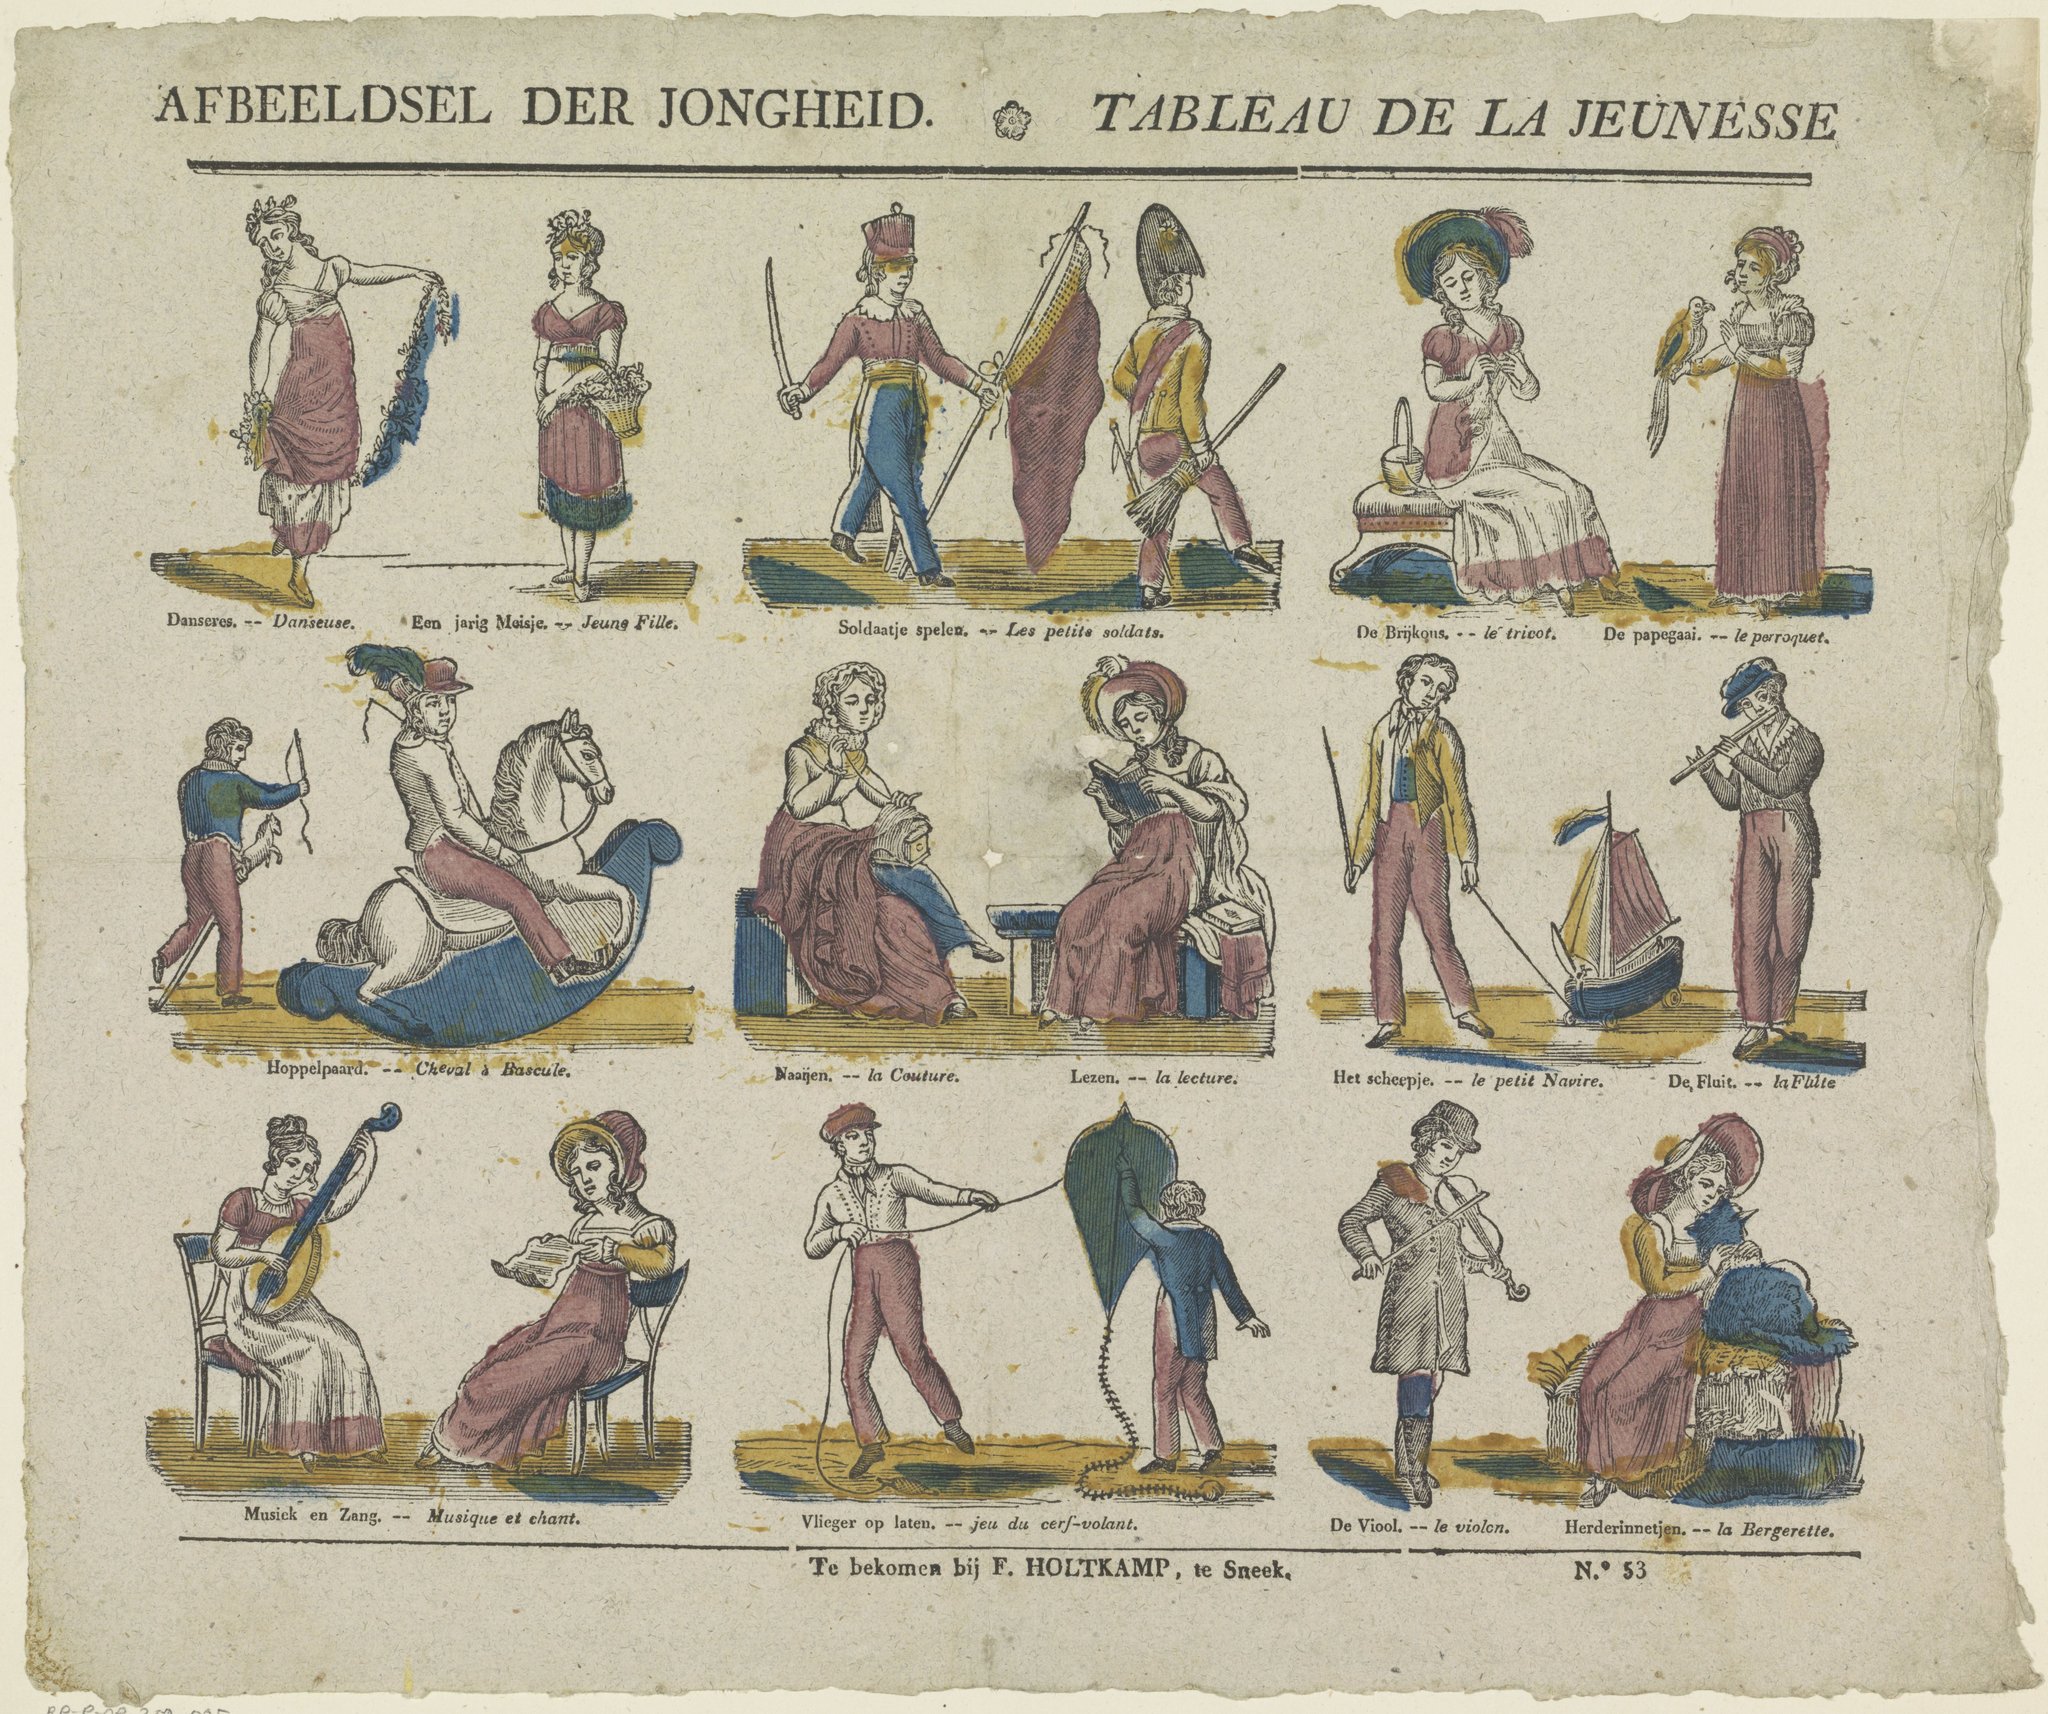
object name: print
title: Afbeeldsel der jongheid / Tableau de la jeunesse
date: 1800-1833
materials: paper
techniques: colour, letterpress printing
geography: sneek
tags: children's games and plays, dancing, (flying a) kite, rocking-horse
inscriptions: collector's mark: Lugt 2760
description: Blad met 9 voorstellingen van kinderspelen en bezigheden, waaronder dansen, soldaatje spelen en vliegeren. Onder elke afbeelding een onderschrift in het Nederlands en in het Frans. Genummerd rechtsonder: No. 53.